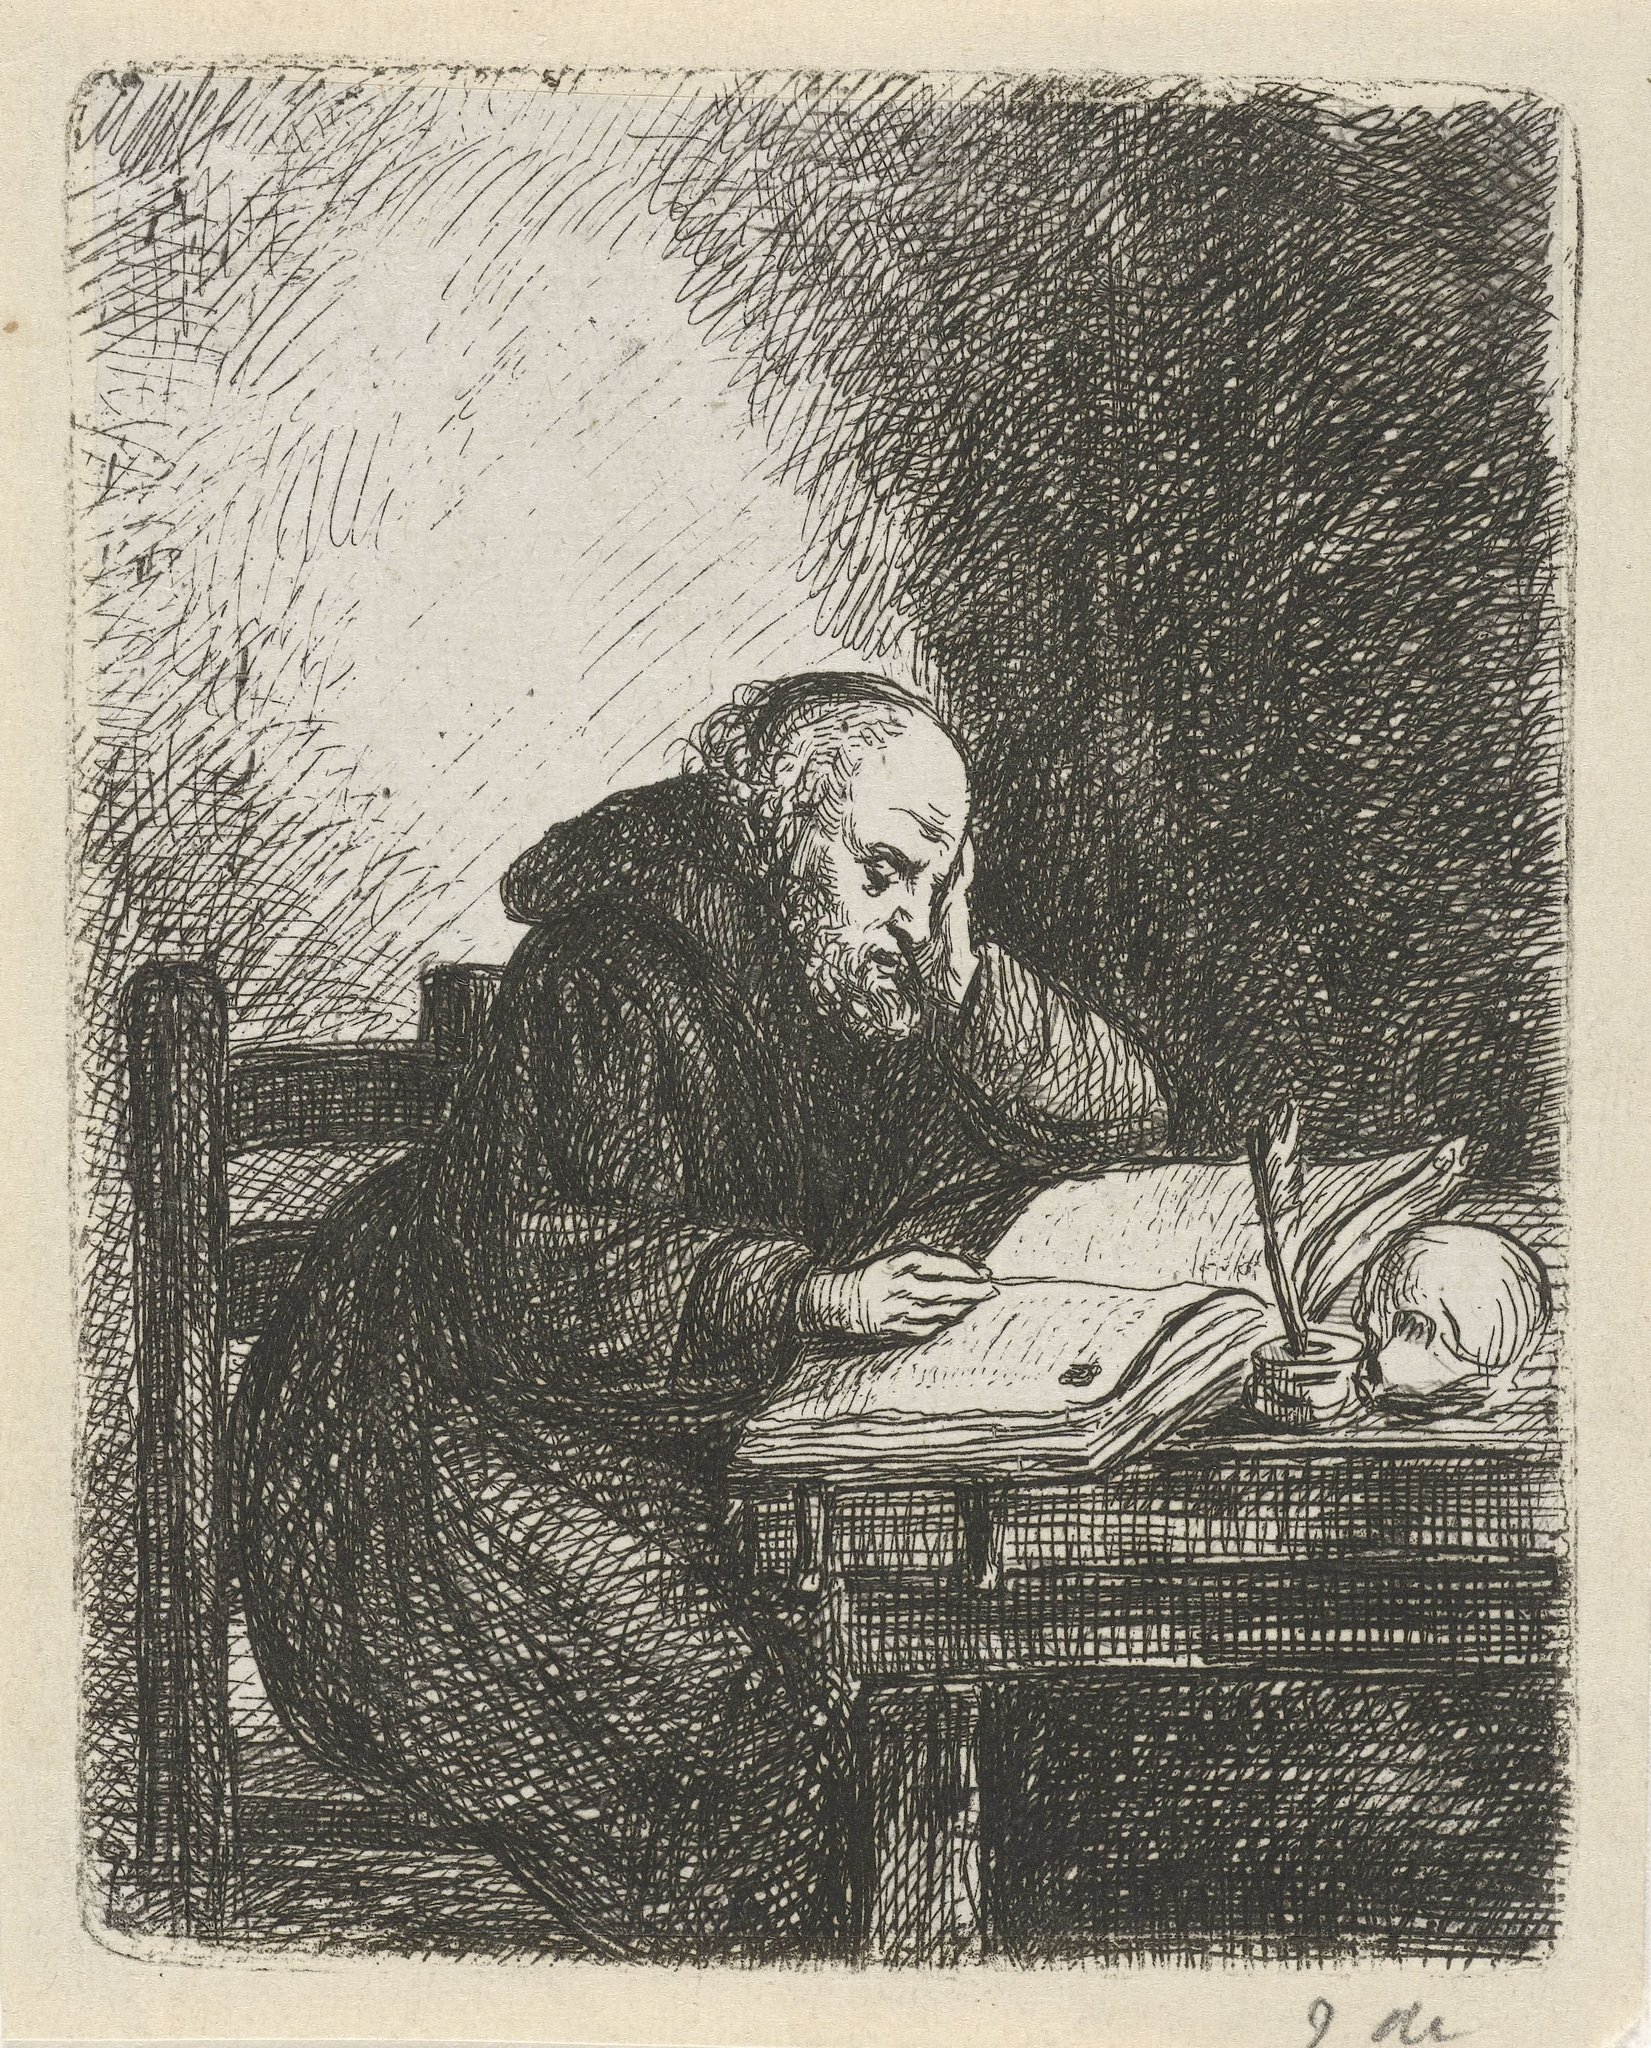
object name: print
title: Lezende monnik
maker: david van der kellen (1804-1879)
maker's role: die cutter, draughtsman, print maker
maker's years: 1804-1879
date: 1814-1879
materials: paper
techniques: etching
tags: reading, (human) skull, monk(s), friar(s)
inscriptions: collector's mark: Lugt 2228, inscription: ‘met de hoofdletter op het rechterblad in den ...’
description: In een vertrek zit een monnik aan tafel een boek te lezen. Op de tafel staan een schedel en een inktpot met daarin een schrijfveer.